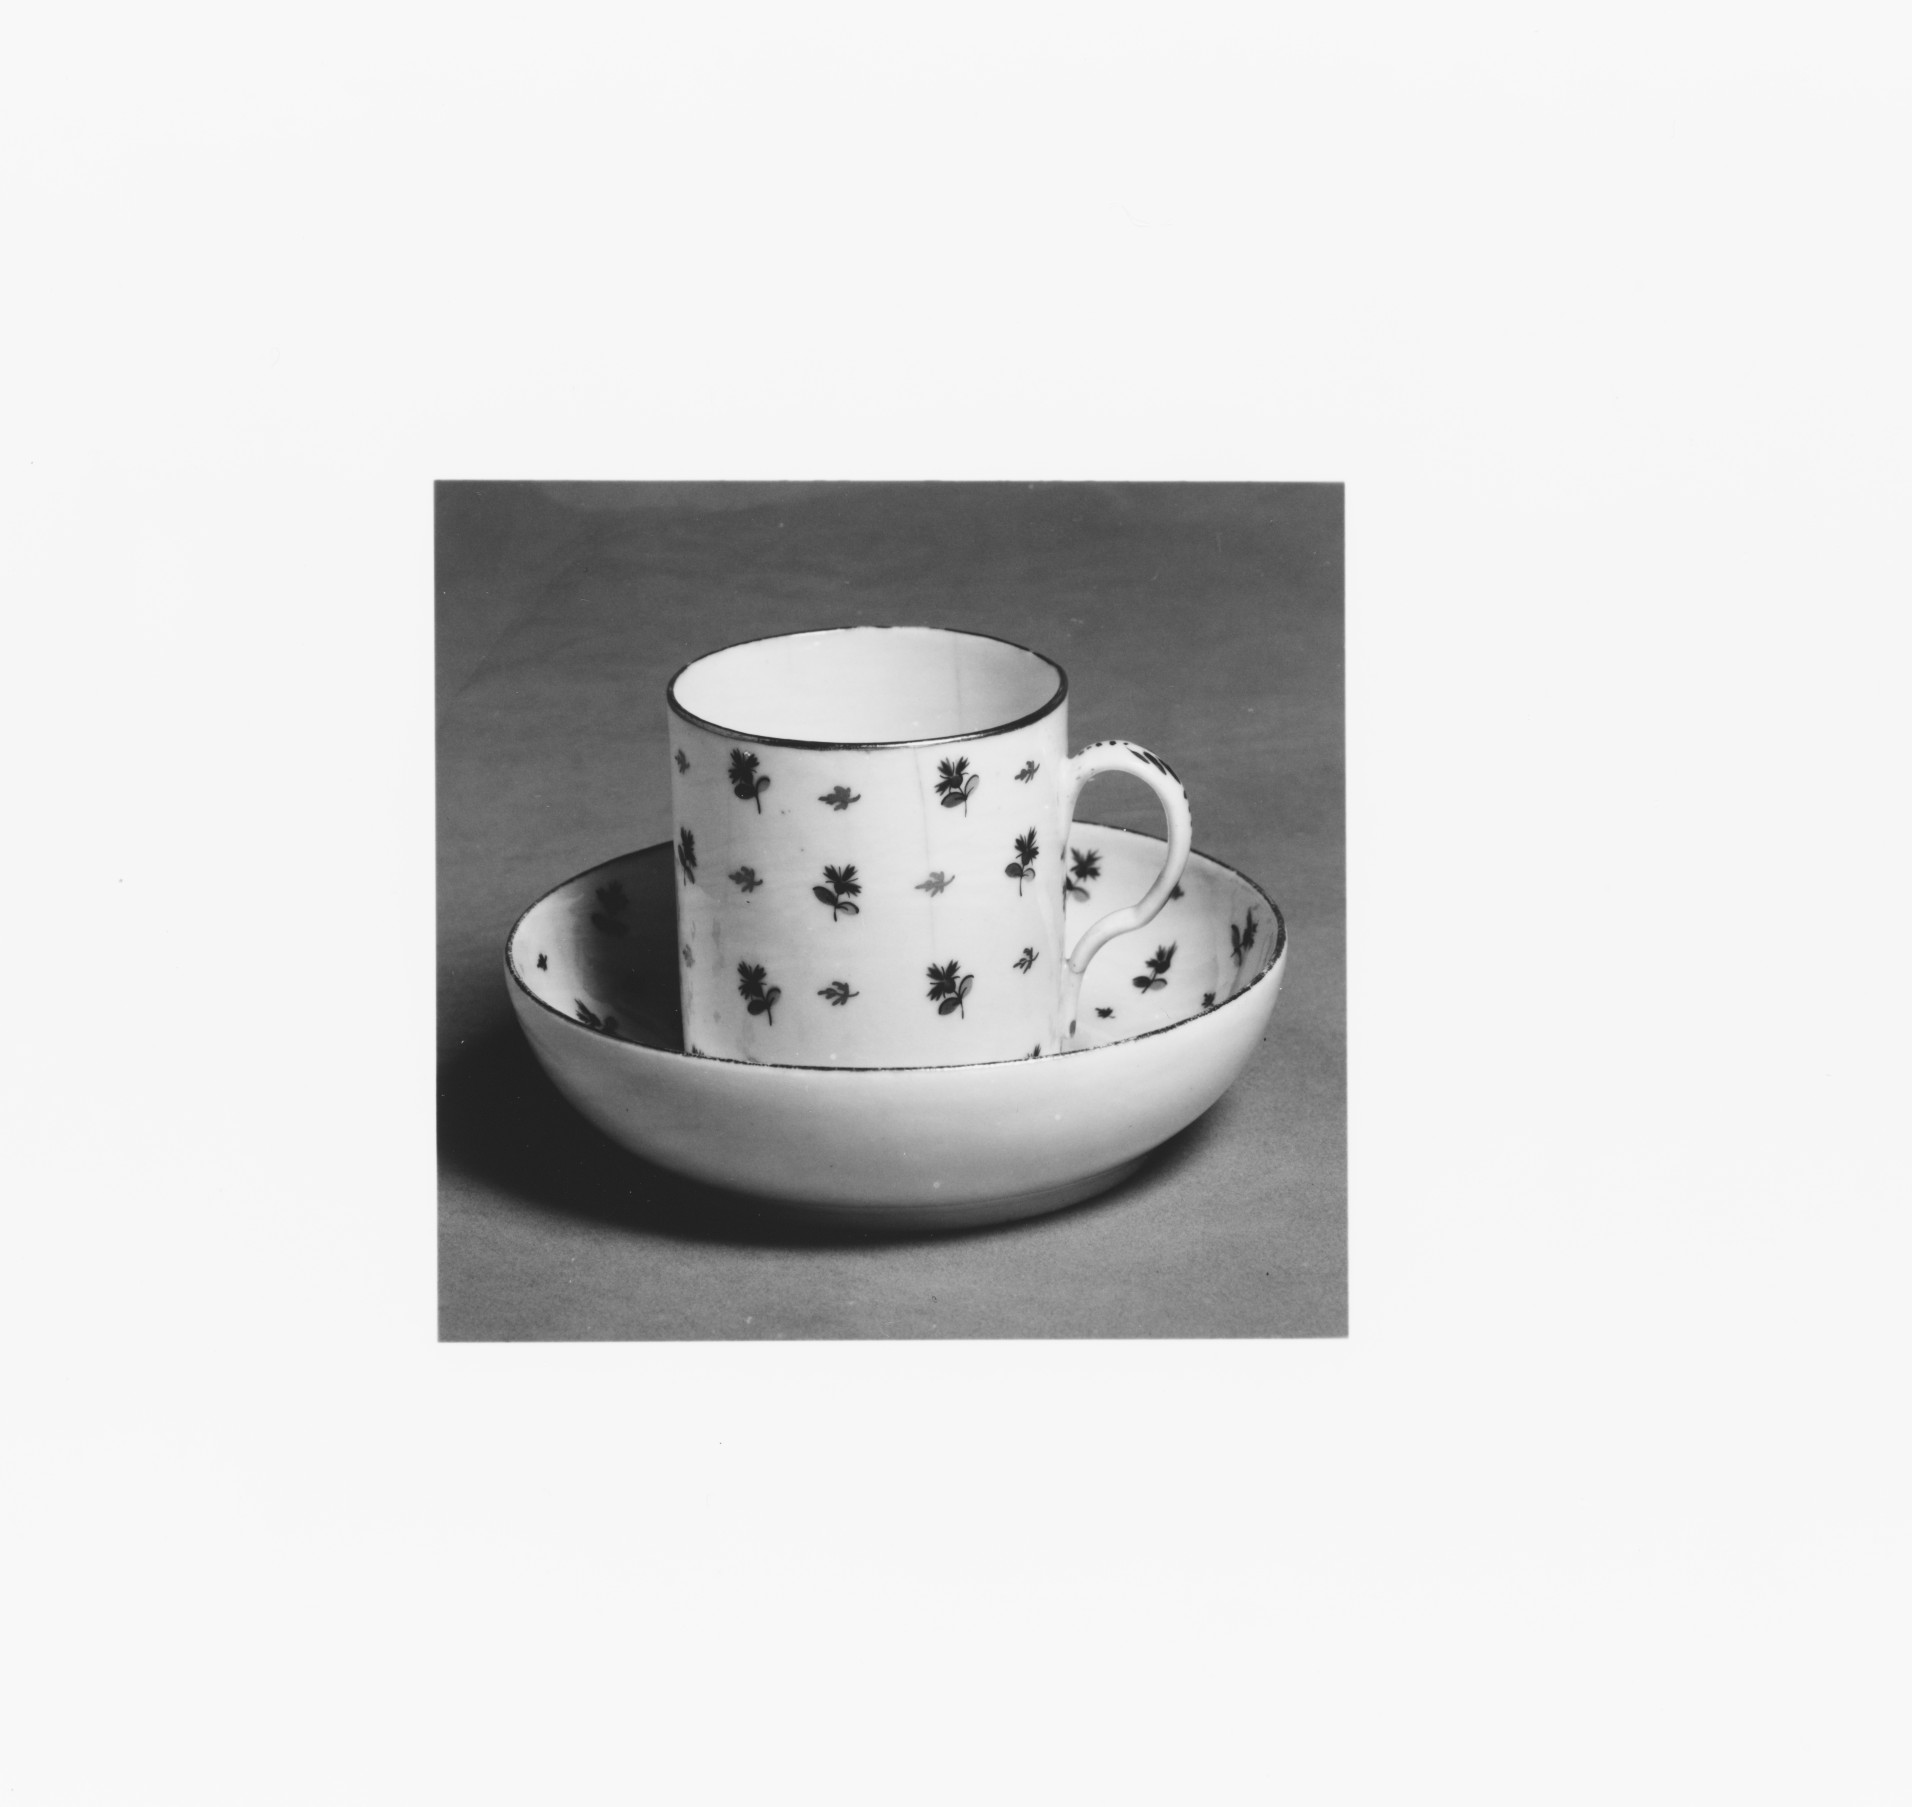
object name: cup and saucer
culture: french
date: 1780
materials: porcelain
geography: france